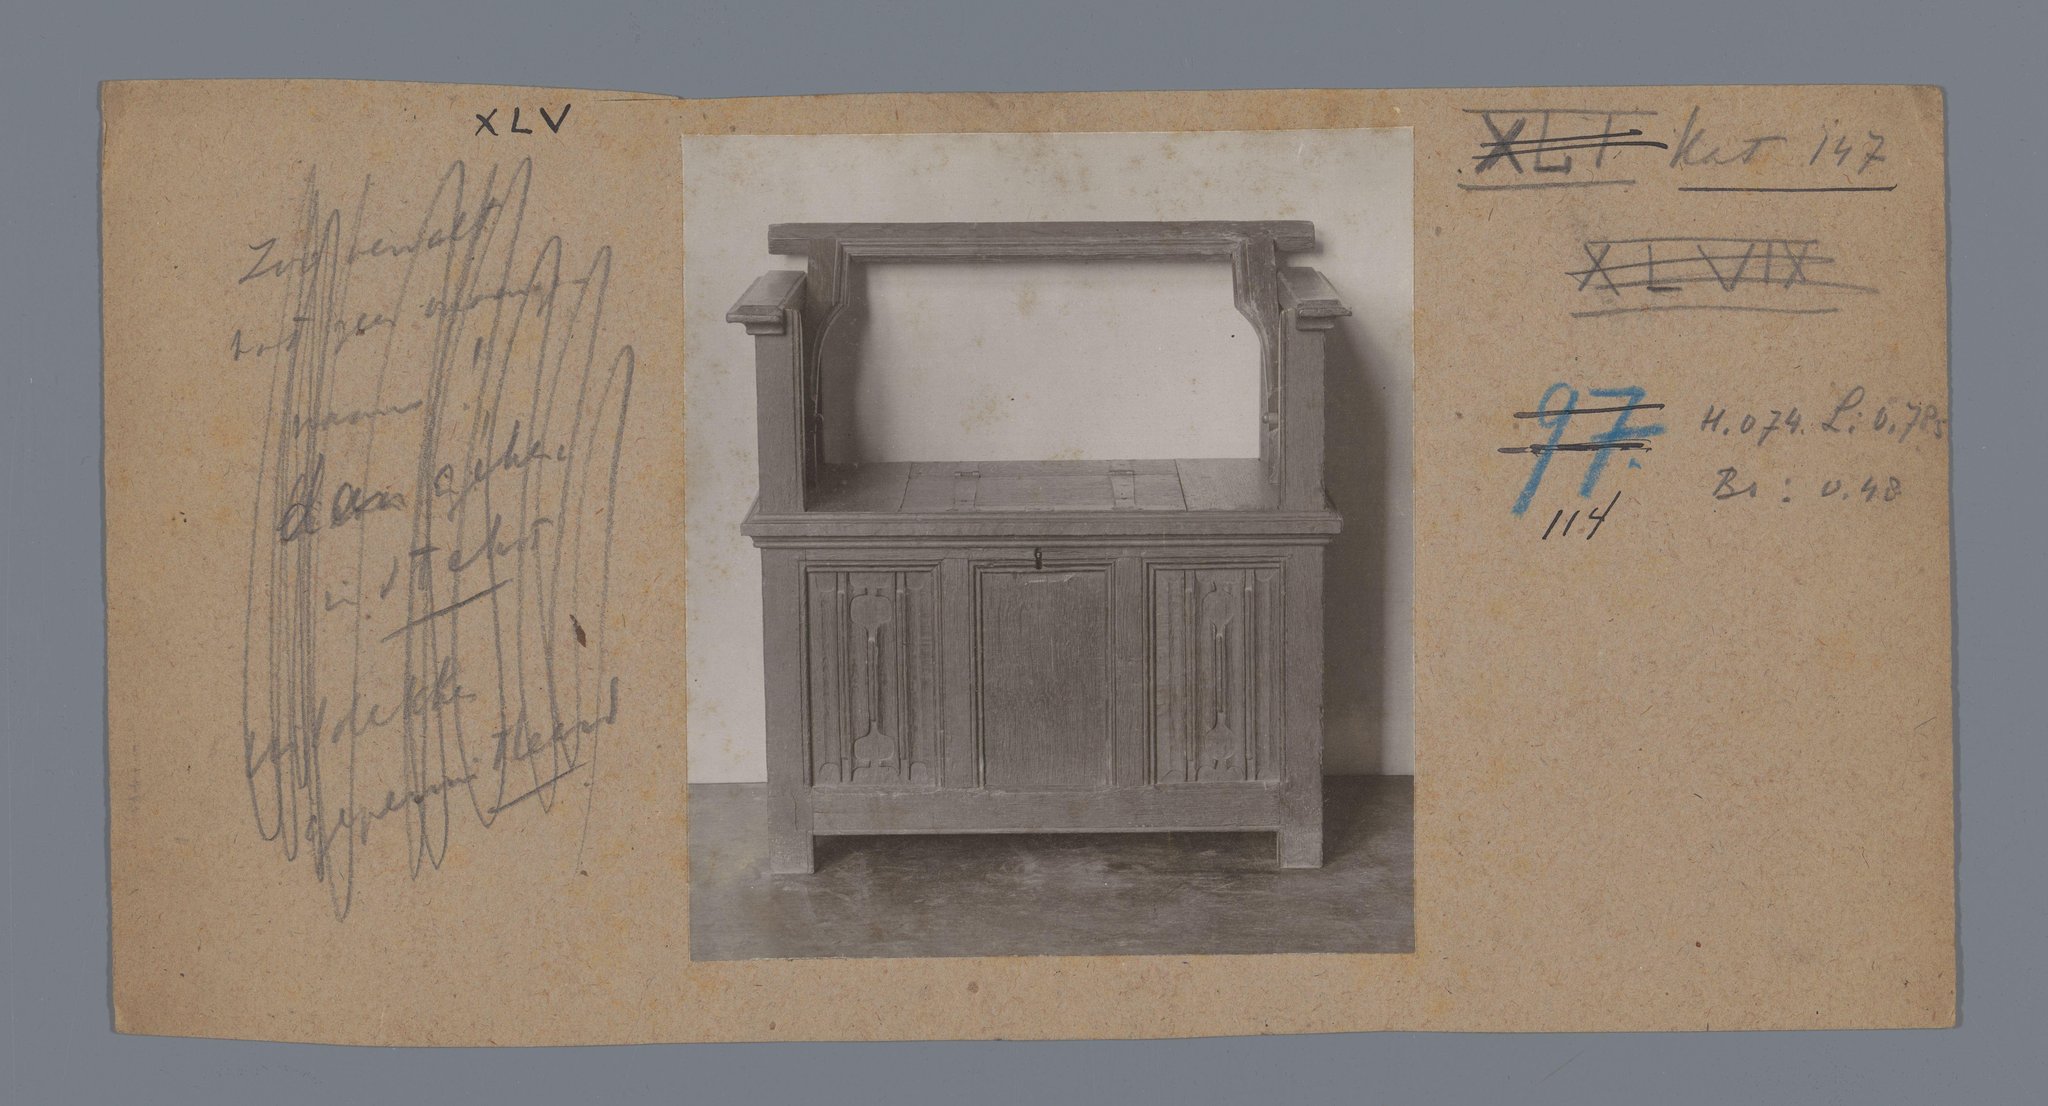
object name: photograph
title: Bank, zogenaamde sittekist, versierd met briefpanelen en met een omklapbare rugleuning in het Rijksmuseum te Amsterdam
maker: Anonymous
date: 1875-1900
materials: photographic support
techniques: matte daylight collodion silver print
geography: amsterdam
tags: bench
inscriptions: number: ‘XLV Kat 147 114’, collector's mark: ‘Instituut voor kunst-nijverheidsonderwijs Gabriël Metsustraat No. 16, Amsterdam’, collector's mark: ‘Kunstnijverheidschool Quellinus Amsterdam Frans Halsstraat 14.’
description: Zie voor het originele object BK-NM-1971.